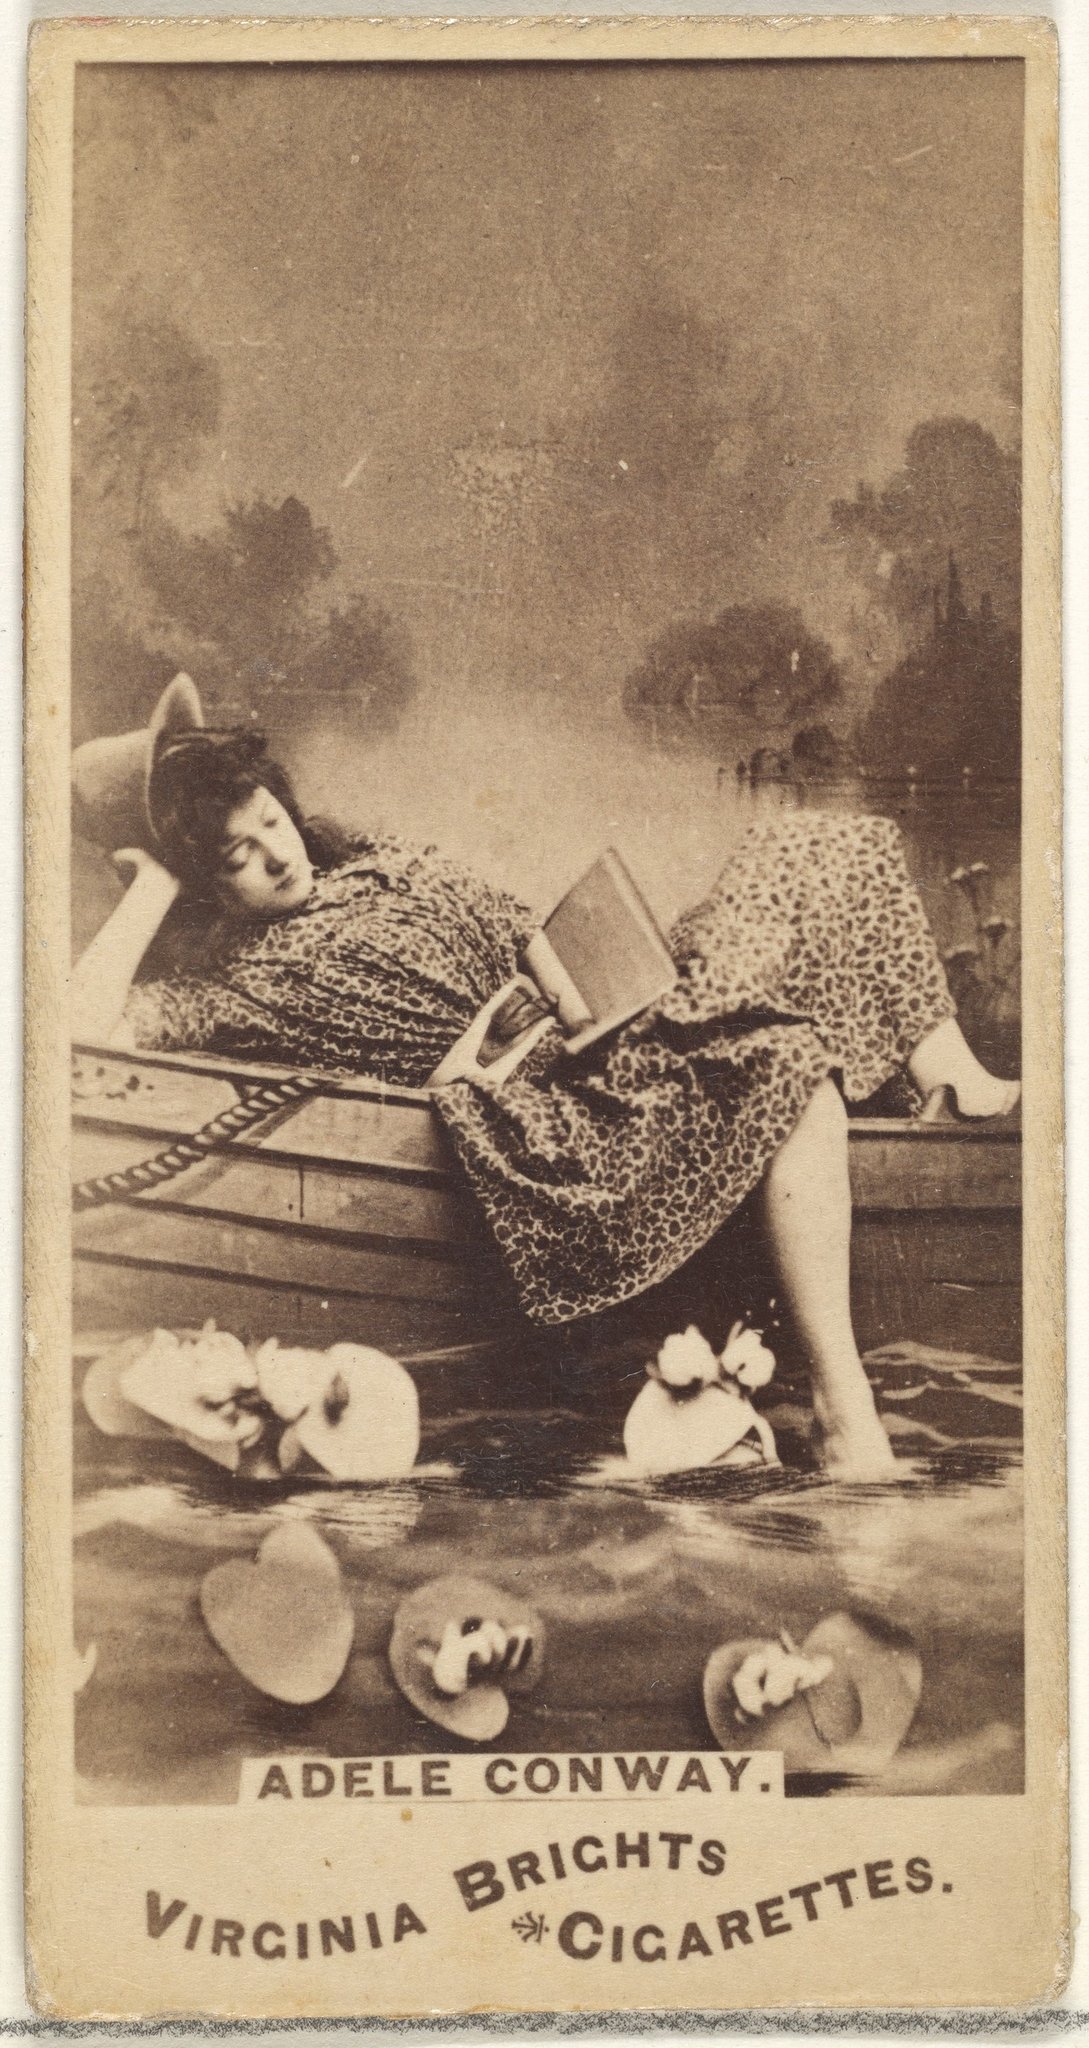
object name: photograph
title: Adele Conway, from the Actors and Actresses series (N45, Type 1) for Virginia Brights Cigarettes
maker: allen & ginter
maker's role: publisher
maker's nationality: american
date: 1888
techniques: albumen silver print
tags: portraits,women,actresses